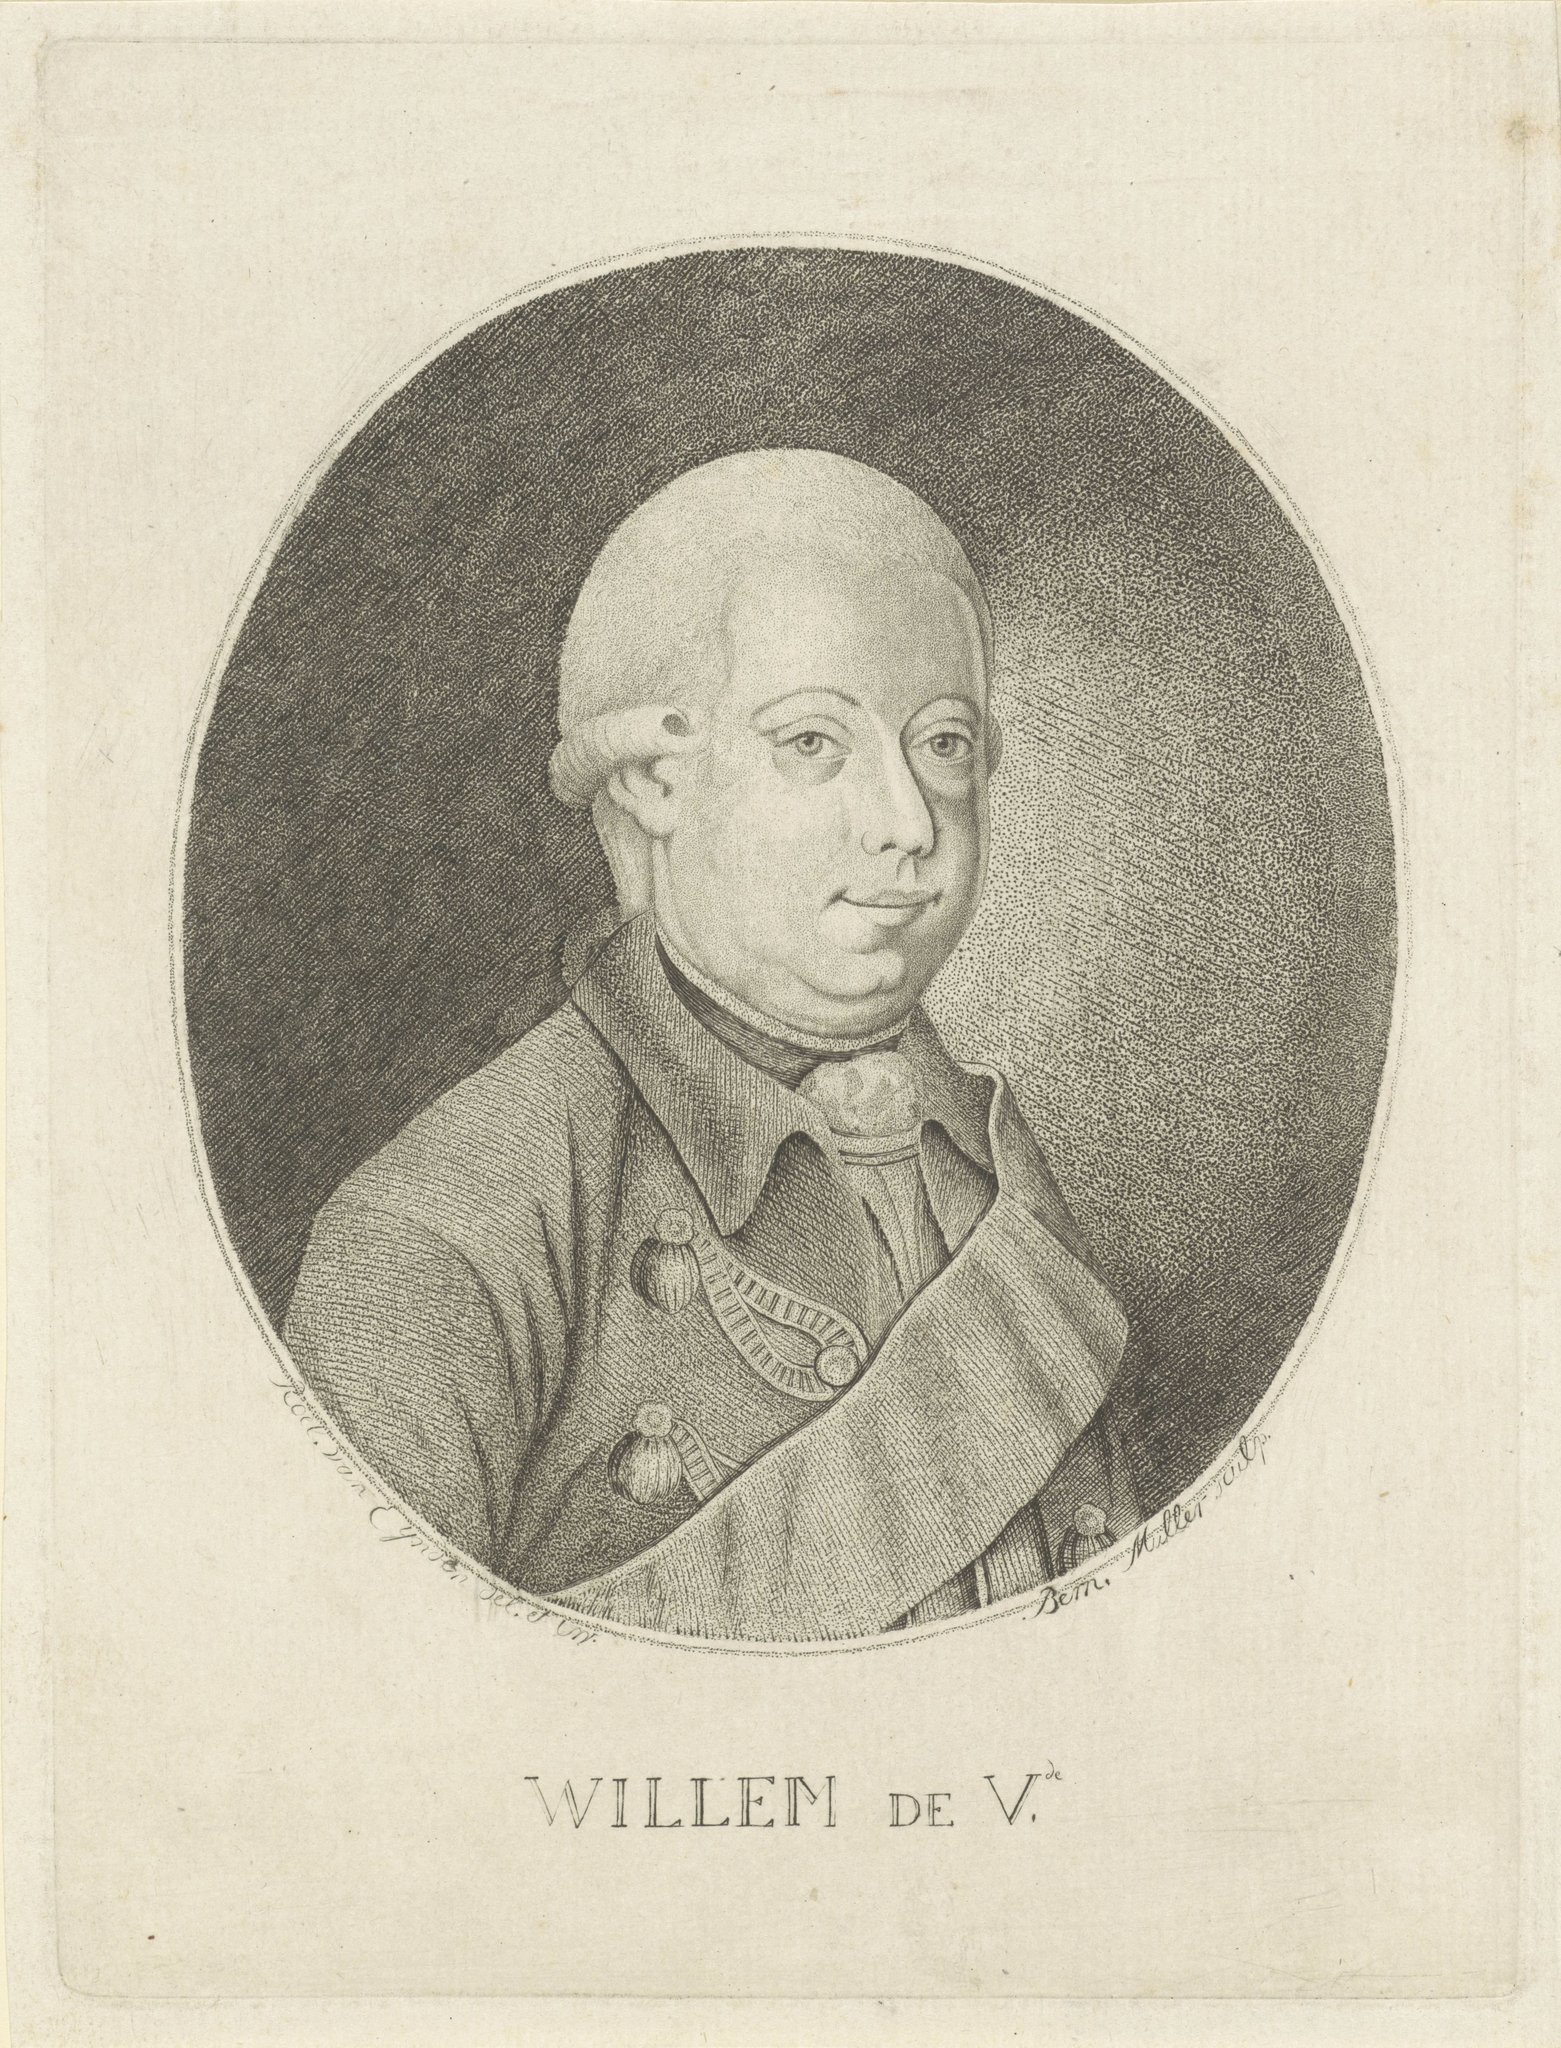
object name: print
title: Portret van Willem V, prins van Oranje-Nassau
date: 1775-1849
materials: paper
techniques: engraving, etching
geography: low countries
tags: william v (prince of orange)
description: De hier vermelde titel verwijst naar de hoogst verkregen titel van de geportretteerde, niet per se naar de titel die de geportretteerde op deze voorstelling draagt.